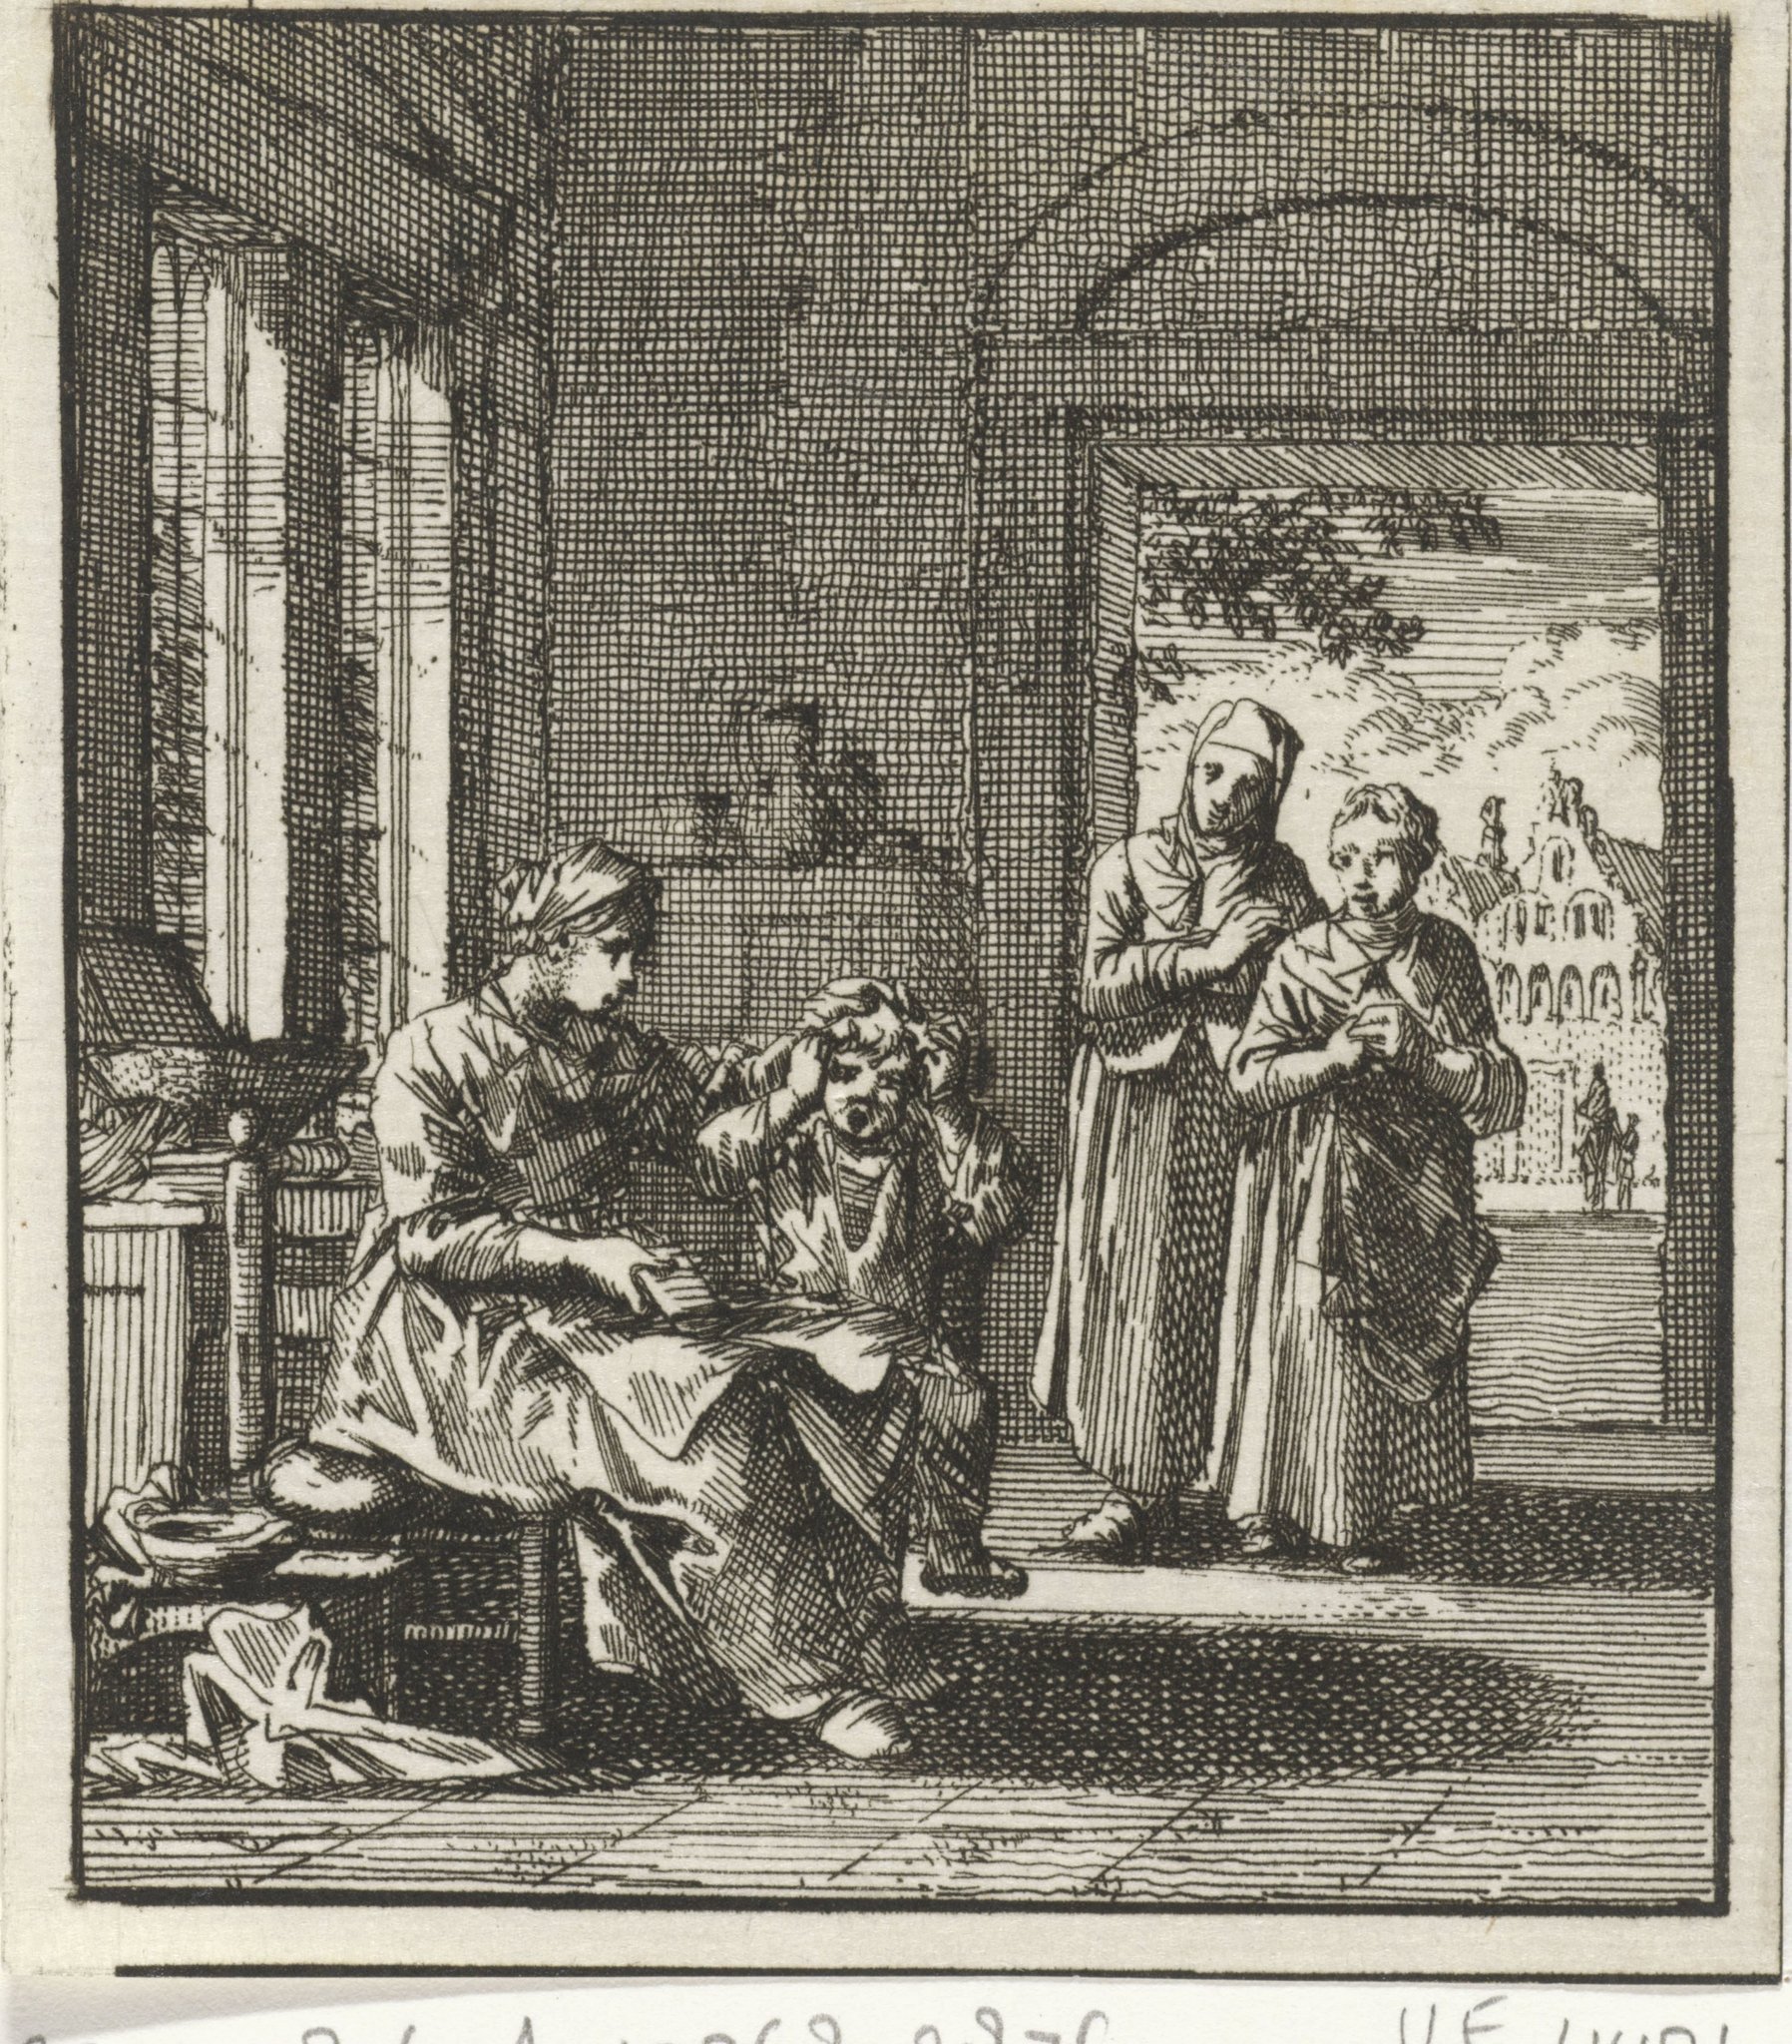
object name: print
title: Het Kindje Gehavend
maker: jan luyken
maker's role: draughtsman, print maker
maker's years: 1649-1712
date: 1712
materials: paper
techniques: etching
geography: amsterdam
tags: combing baby's hair, mother and baby or young child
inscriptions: collector's mark: Lugt 2228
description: Proefdruk van illustratie uit: Luyken, Jan. Des menschen begin, midden en einde. Amsterdam: Wed. Pieter Arentsz II en Cornelis van der Sys, 1712, p. 27.